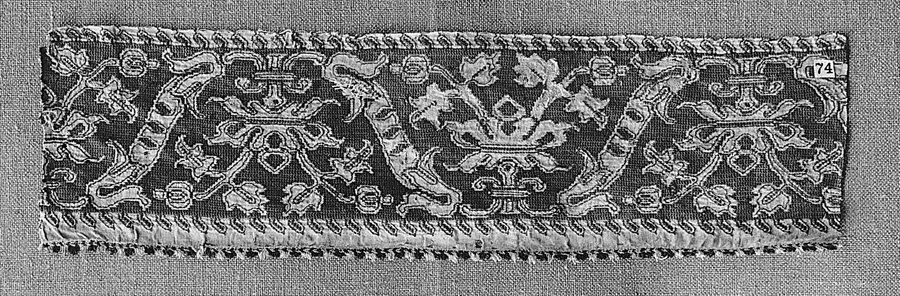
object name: band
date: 1501-1700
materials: linen, silk